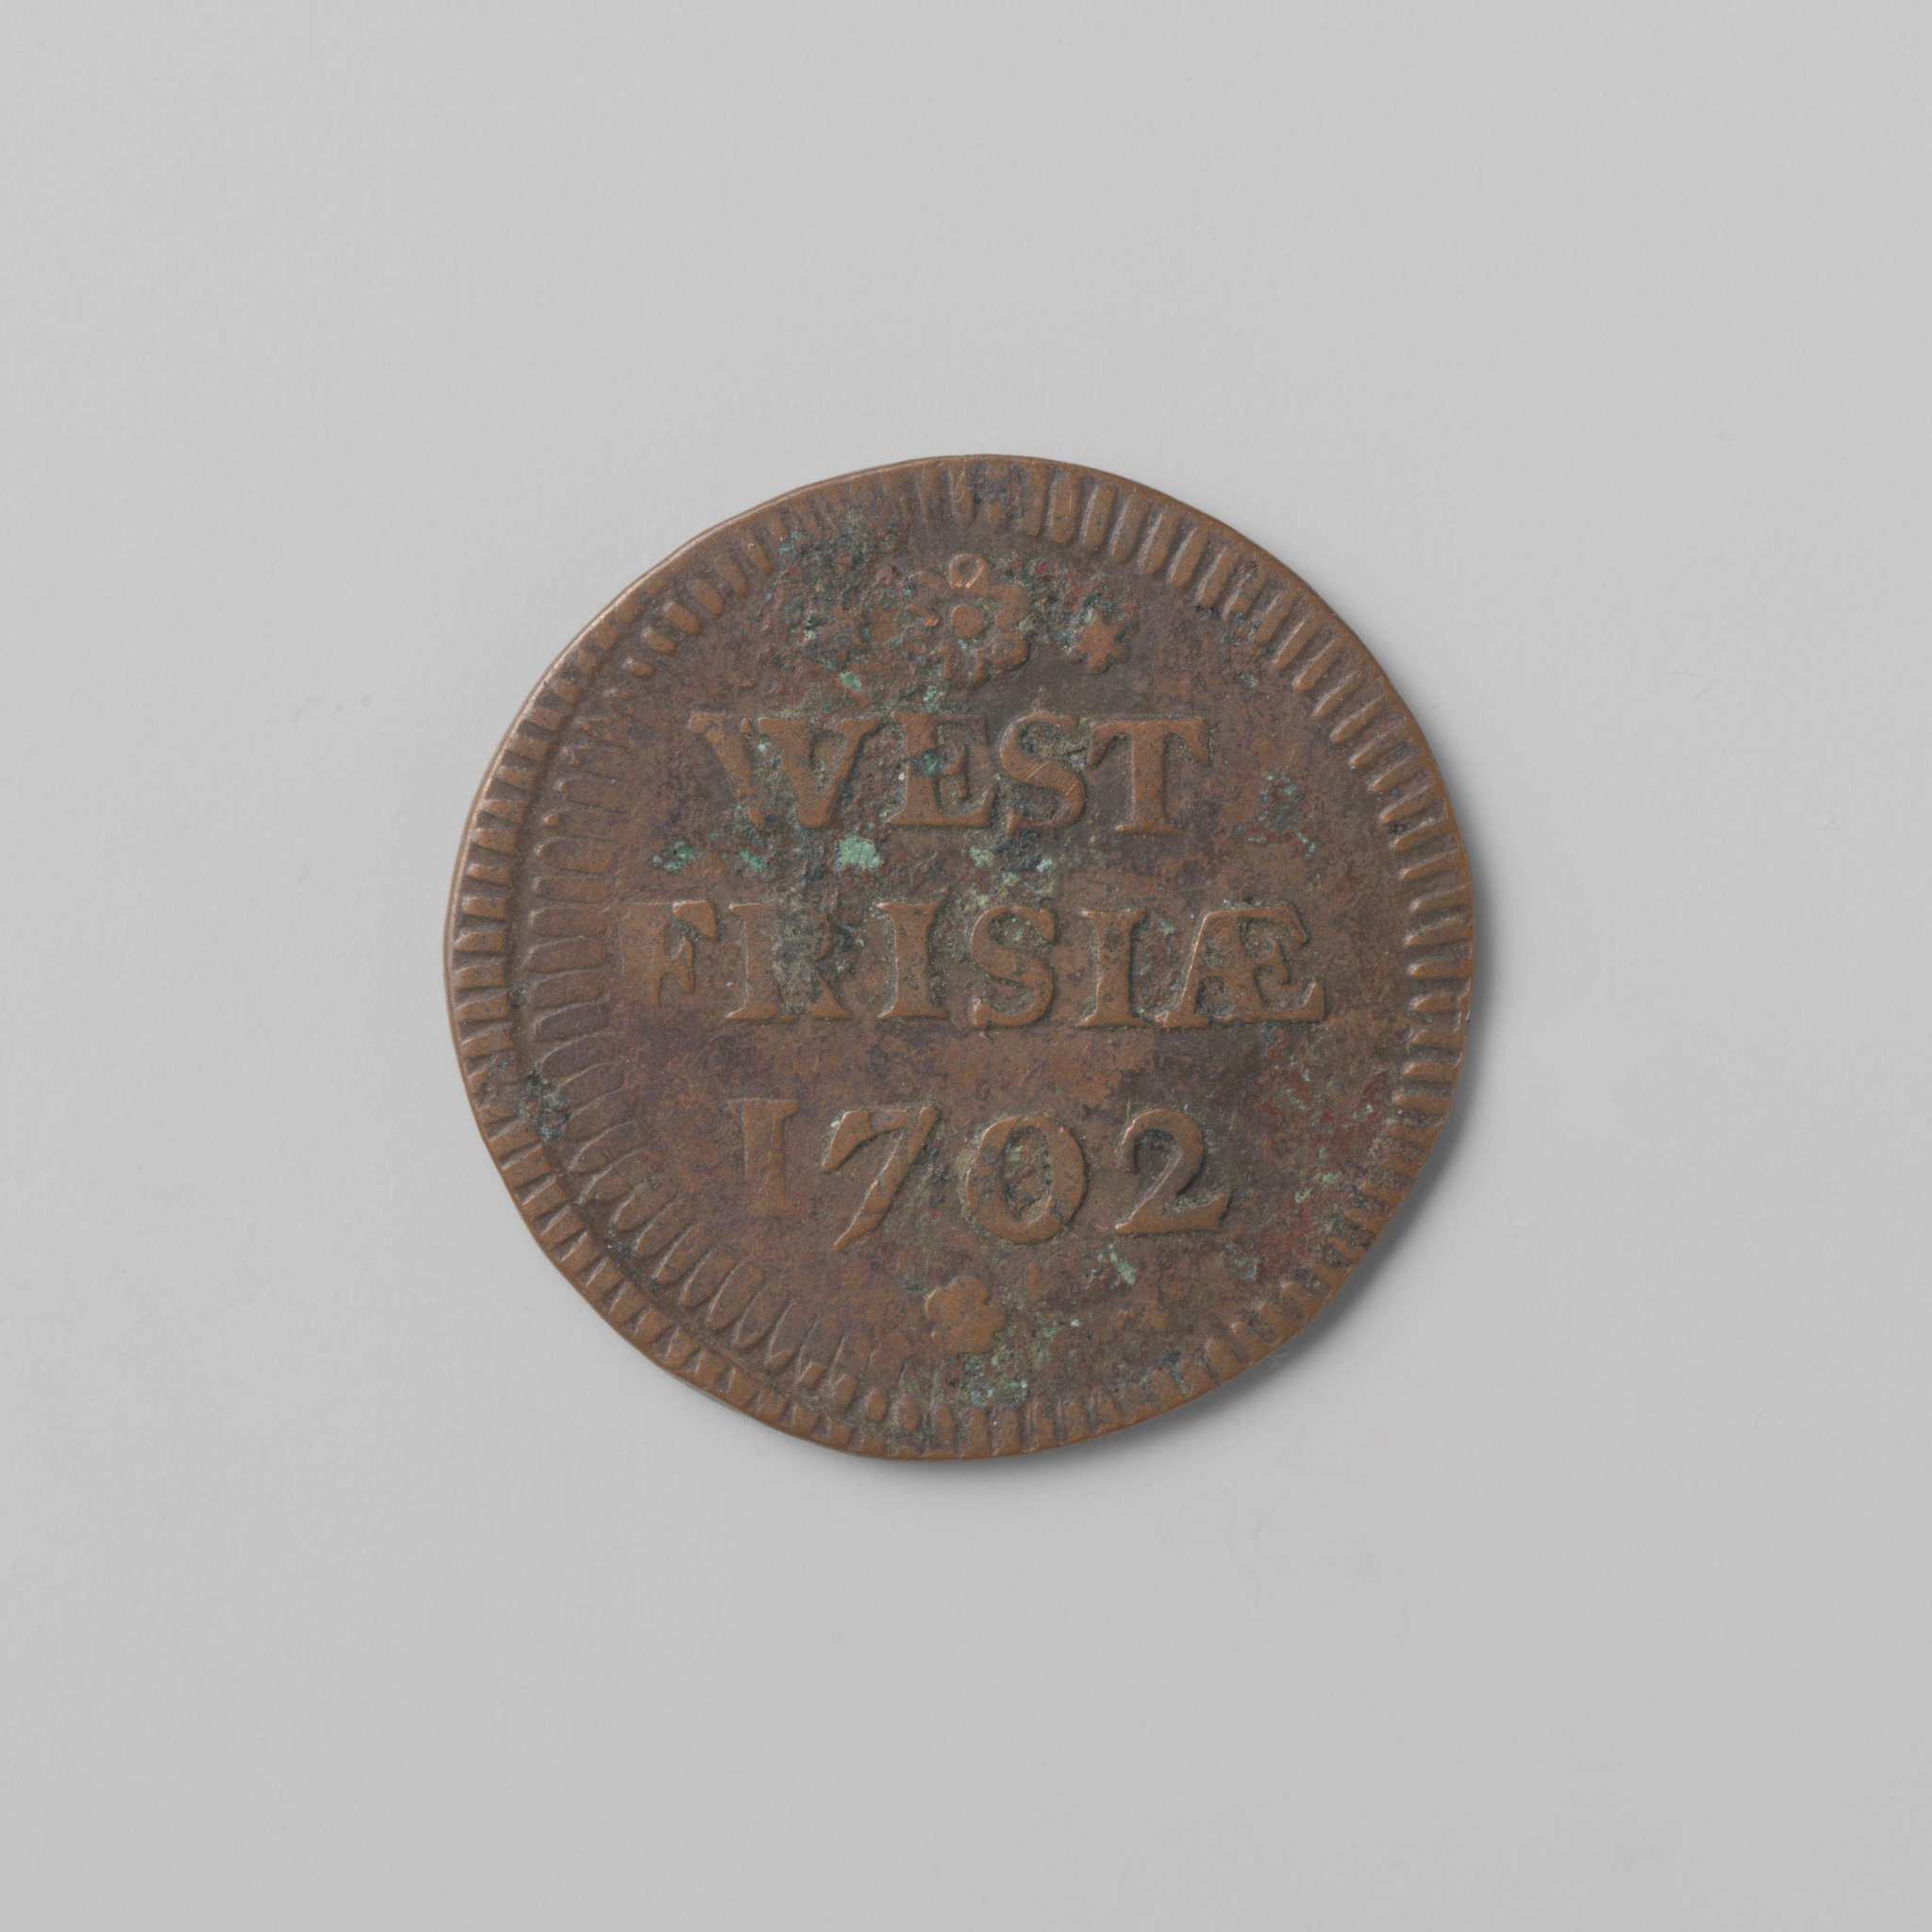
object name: coin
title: West-Friesland, duit, 1702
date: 1702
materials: copper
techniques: striking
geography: west frisia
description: Koperen munt. Voorzijde: gekroond wapenschild van West-Friesland met lauwertakken. Keerzijde: opschrift in twee regels. Daarboven muntmeesterteken rozet tussen twee sterretjes. Daaronder jaartal, waaronder ster.